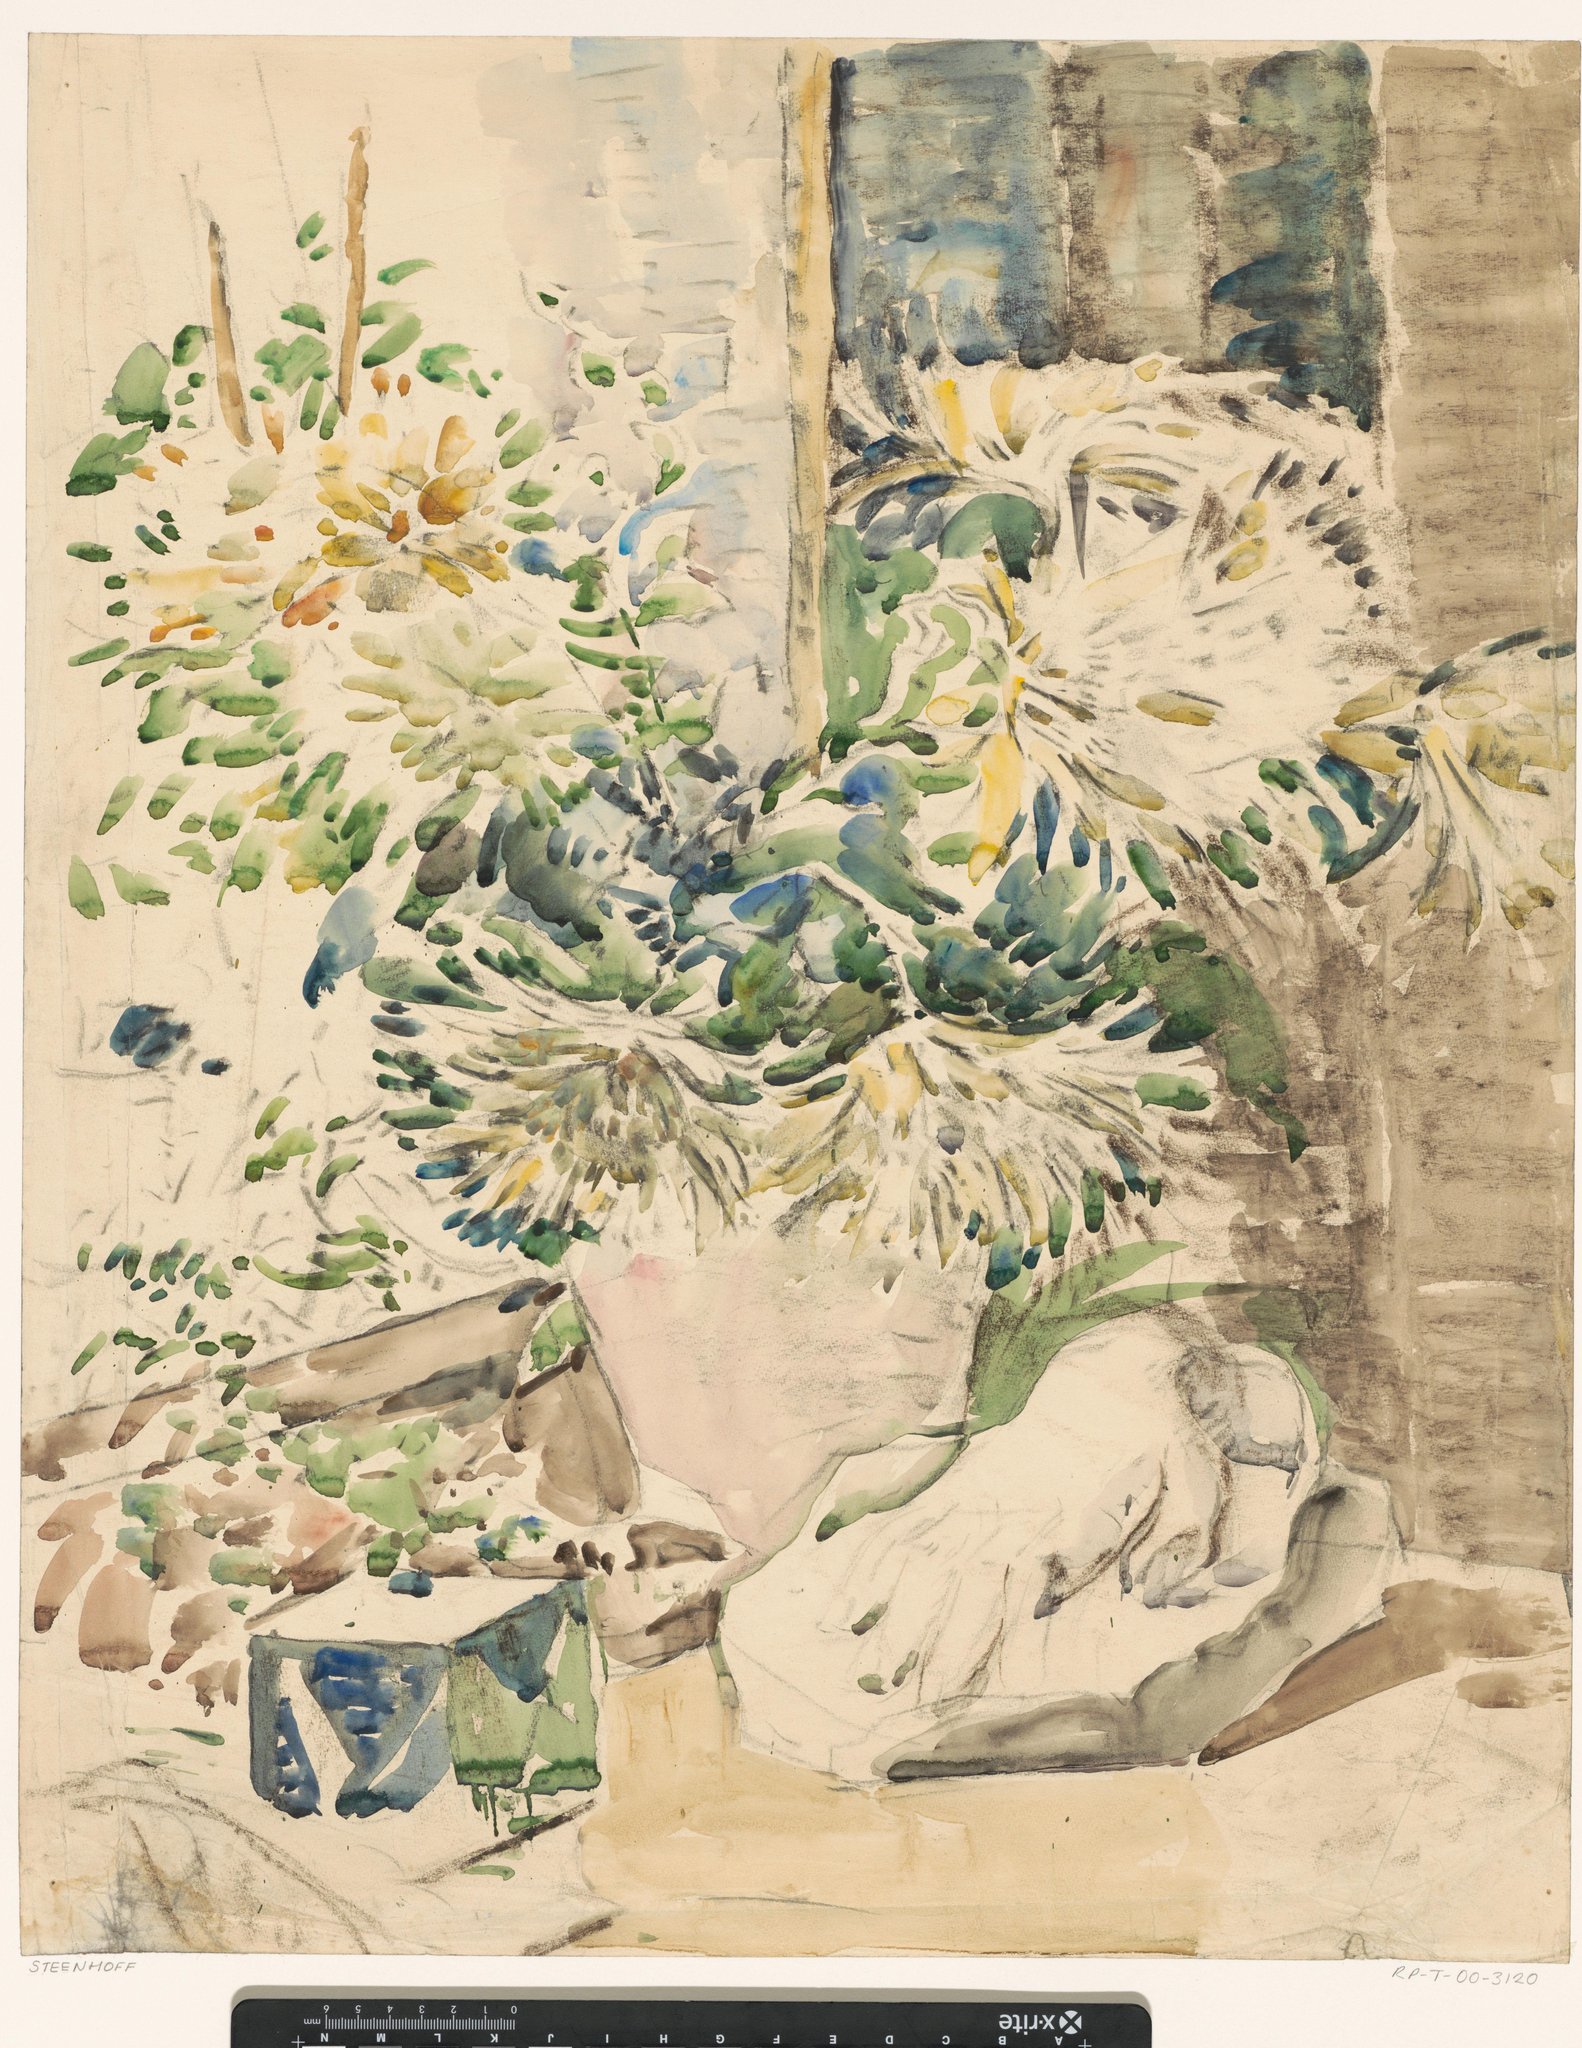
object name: drawing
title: Stilleven met bloemen in een vaas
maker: steenhoff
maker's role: draughtsman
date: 1800-1900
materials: chalk, paper, watercolor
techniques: brush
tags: flowers in a vase